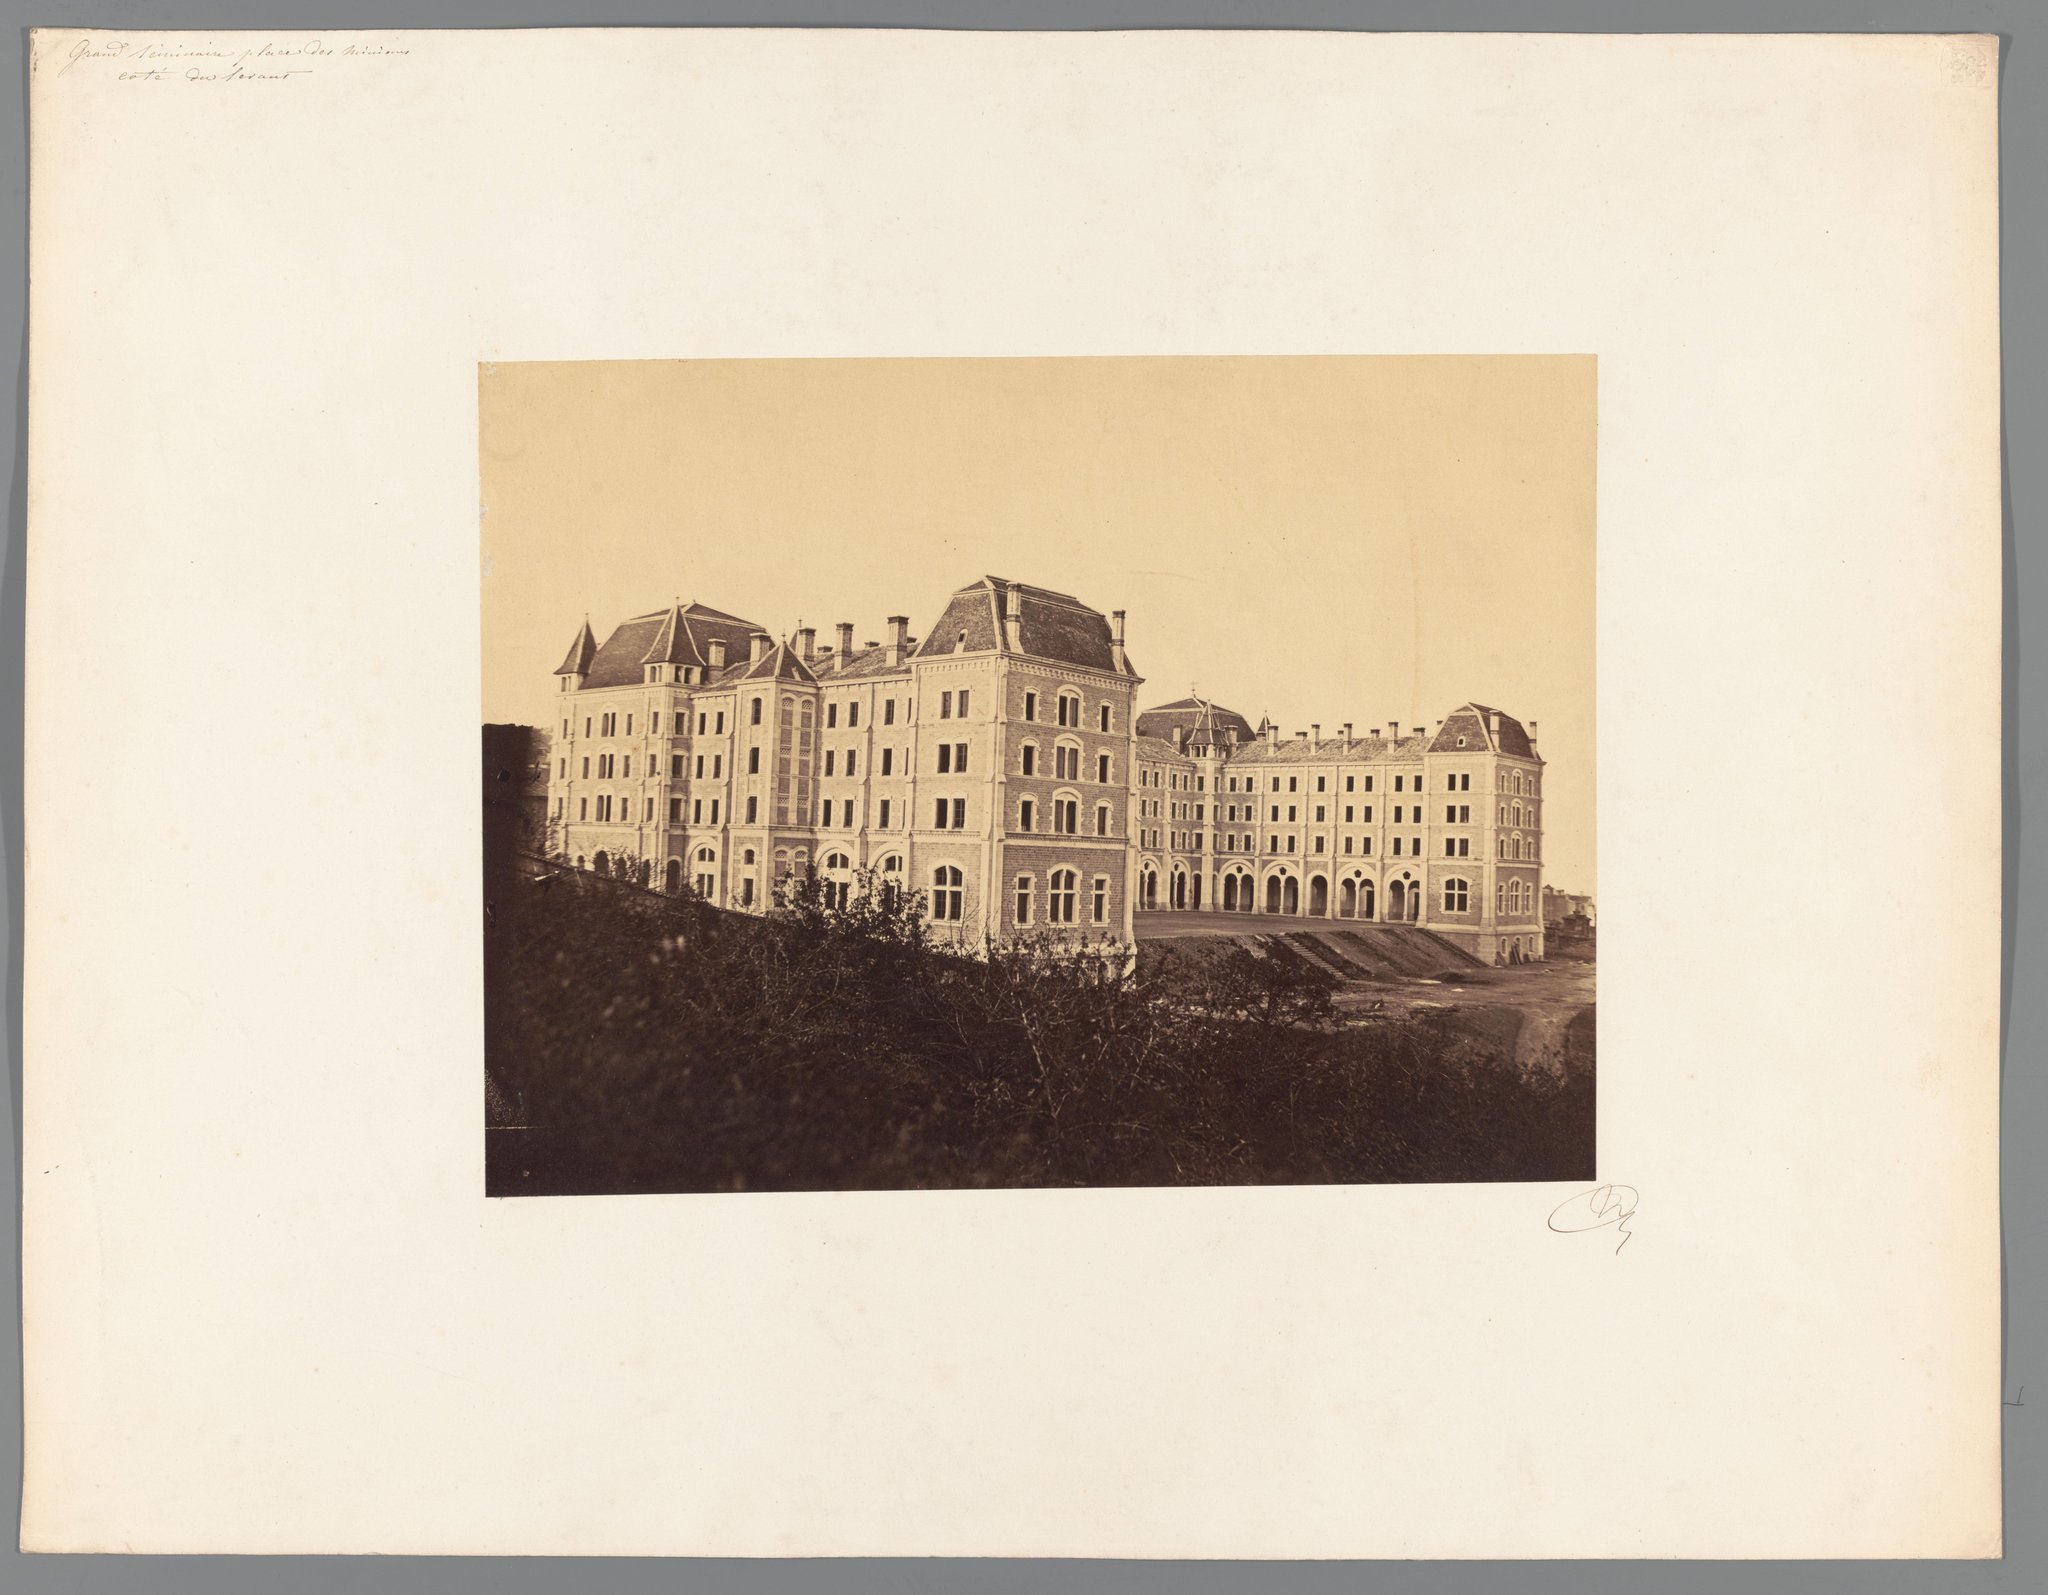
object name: photograph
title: Séminaire Place des minisieurs [onz.], Frankrijk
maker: Anonymous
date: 1870-1880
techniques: albumen print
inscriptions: signature